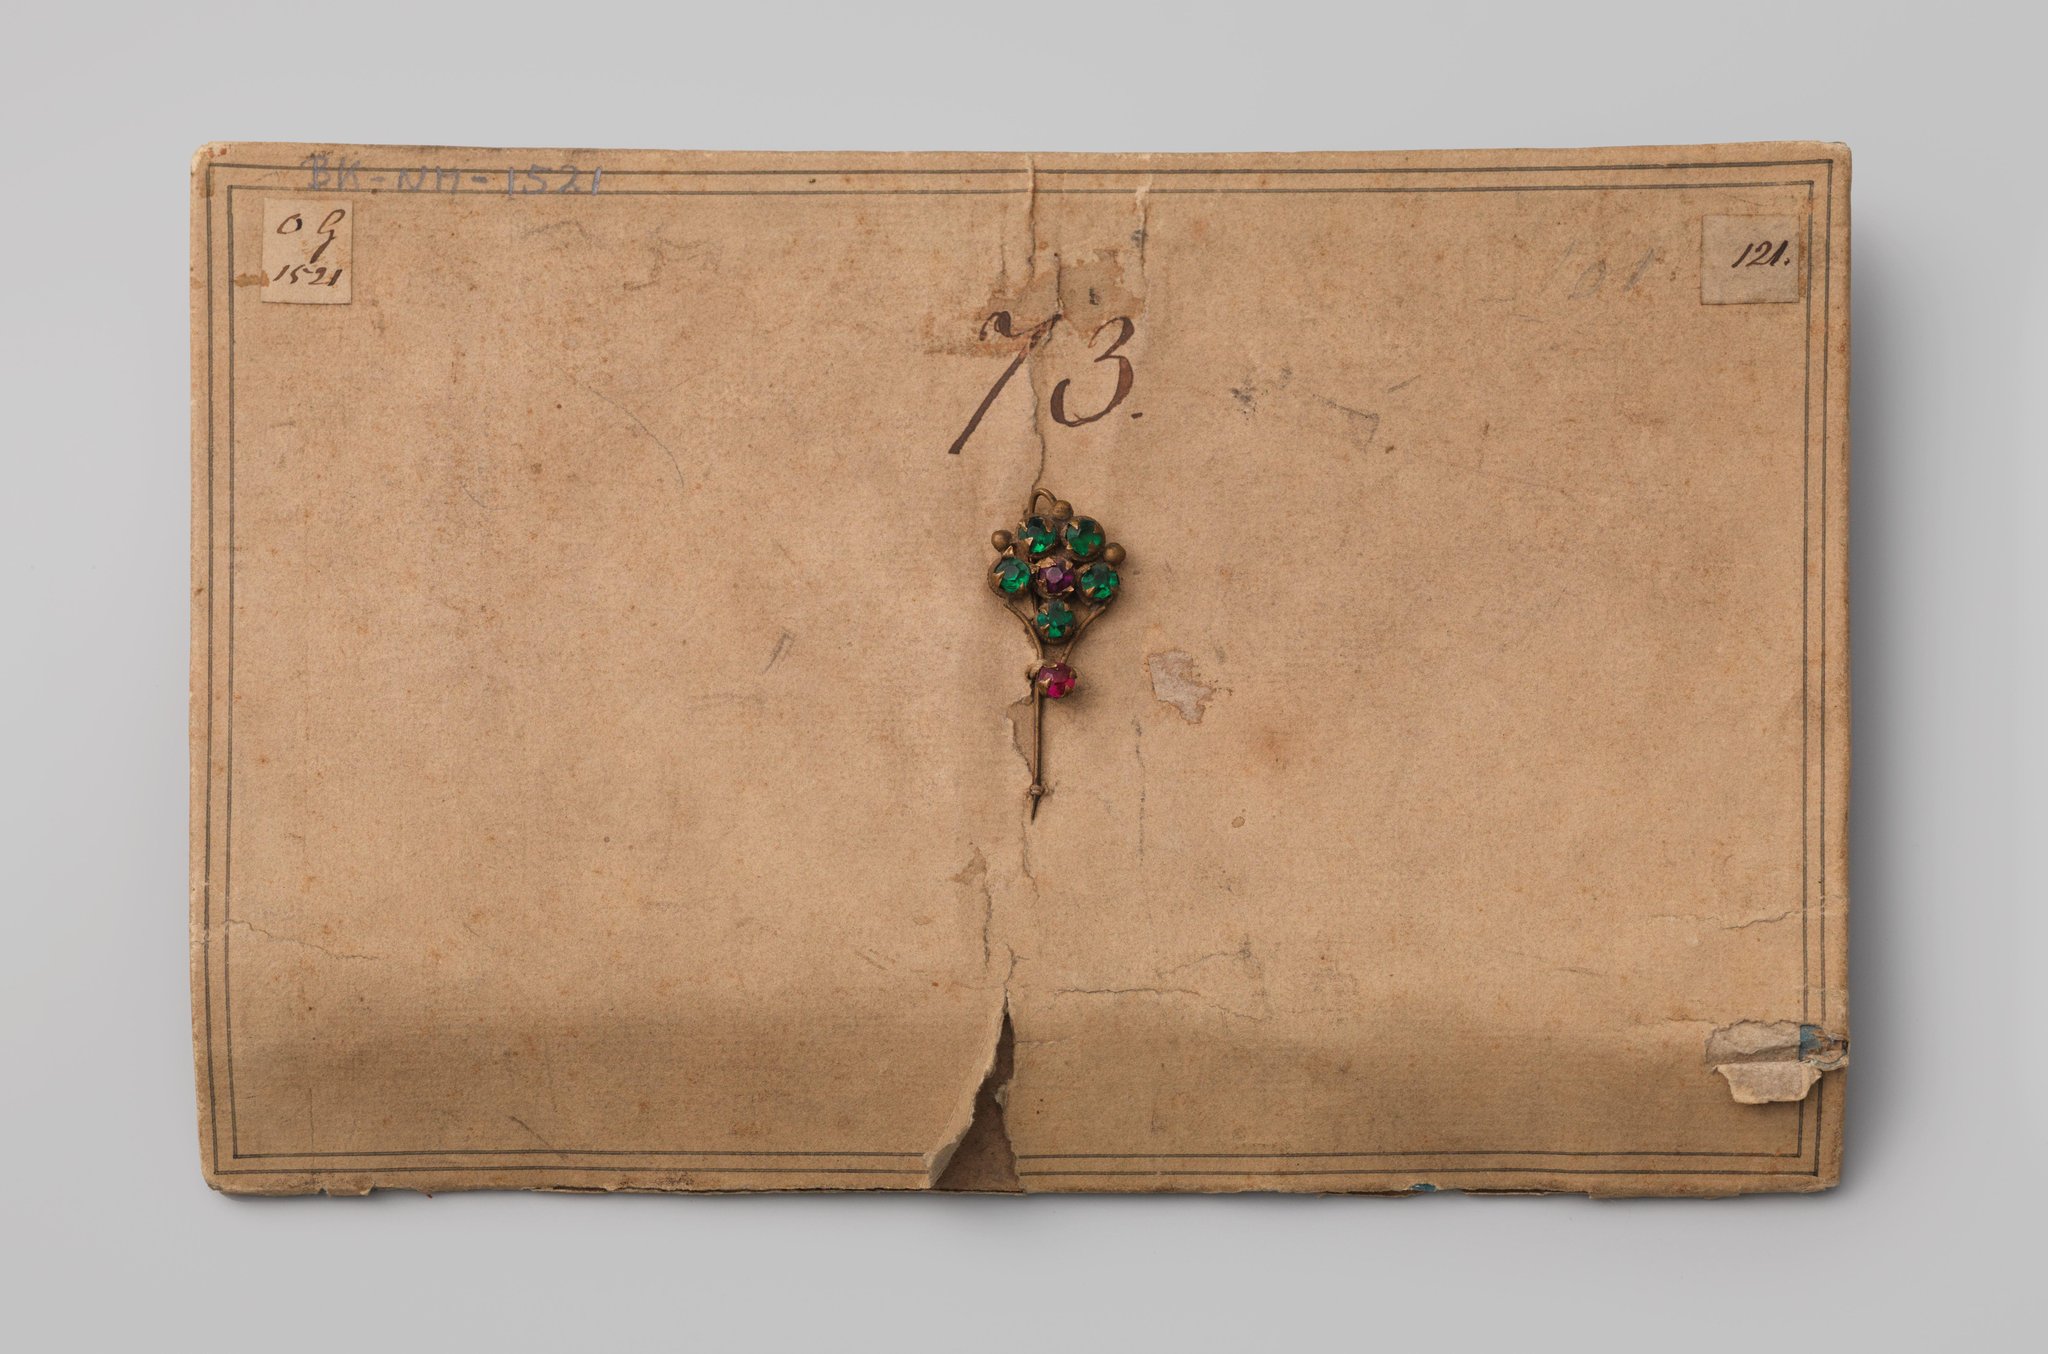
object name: doekspeld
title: Doekspeld met gekleurde steentjes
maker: Anonymous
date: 1750-1850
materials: gold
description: Doekspeld met gekleurde steentjes. Vastgespeld aan karton met lakzegel.